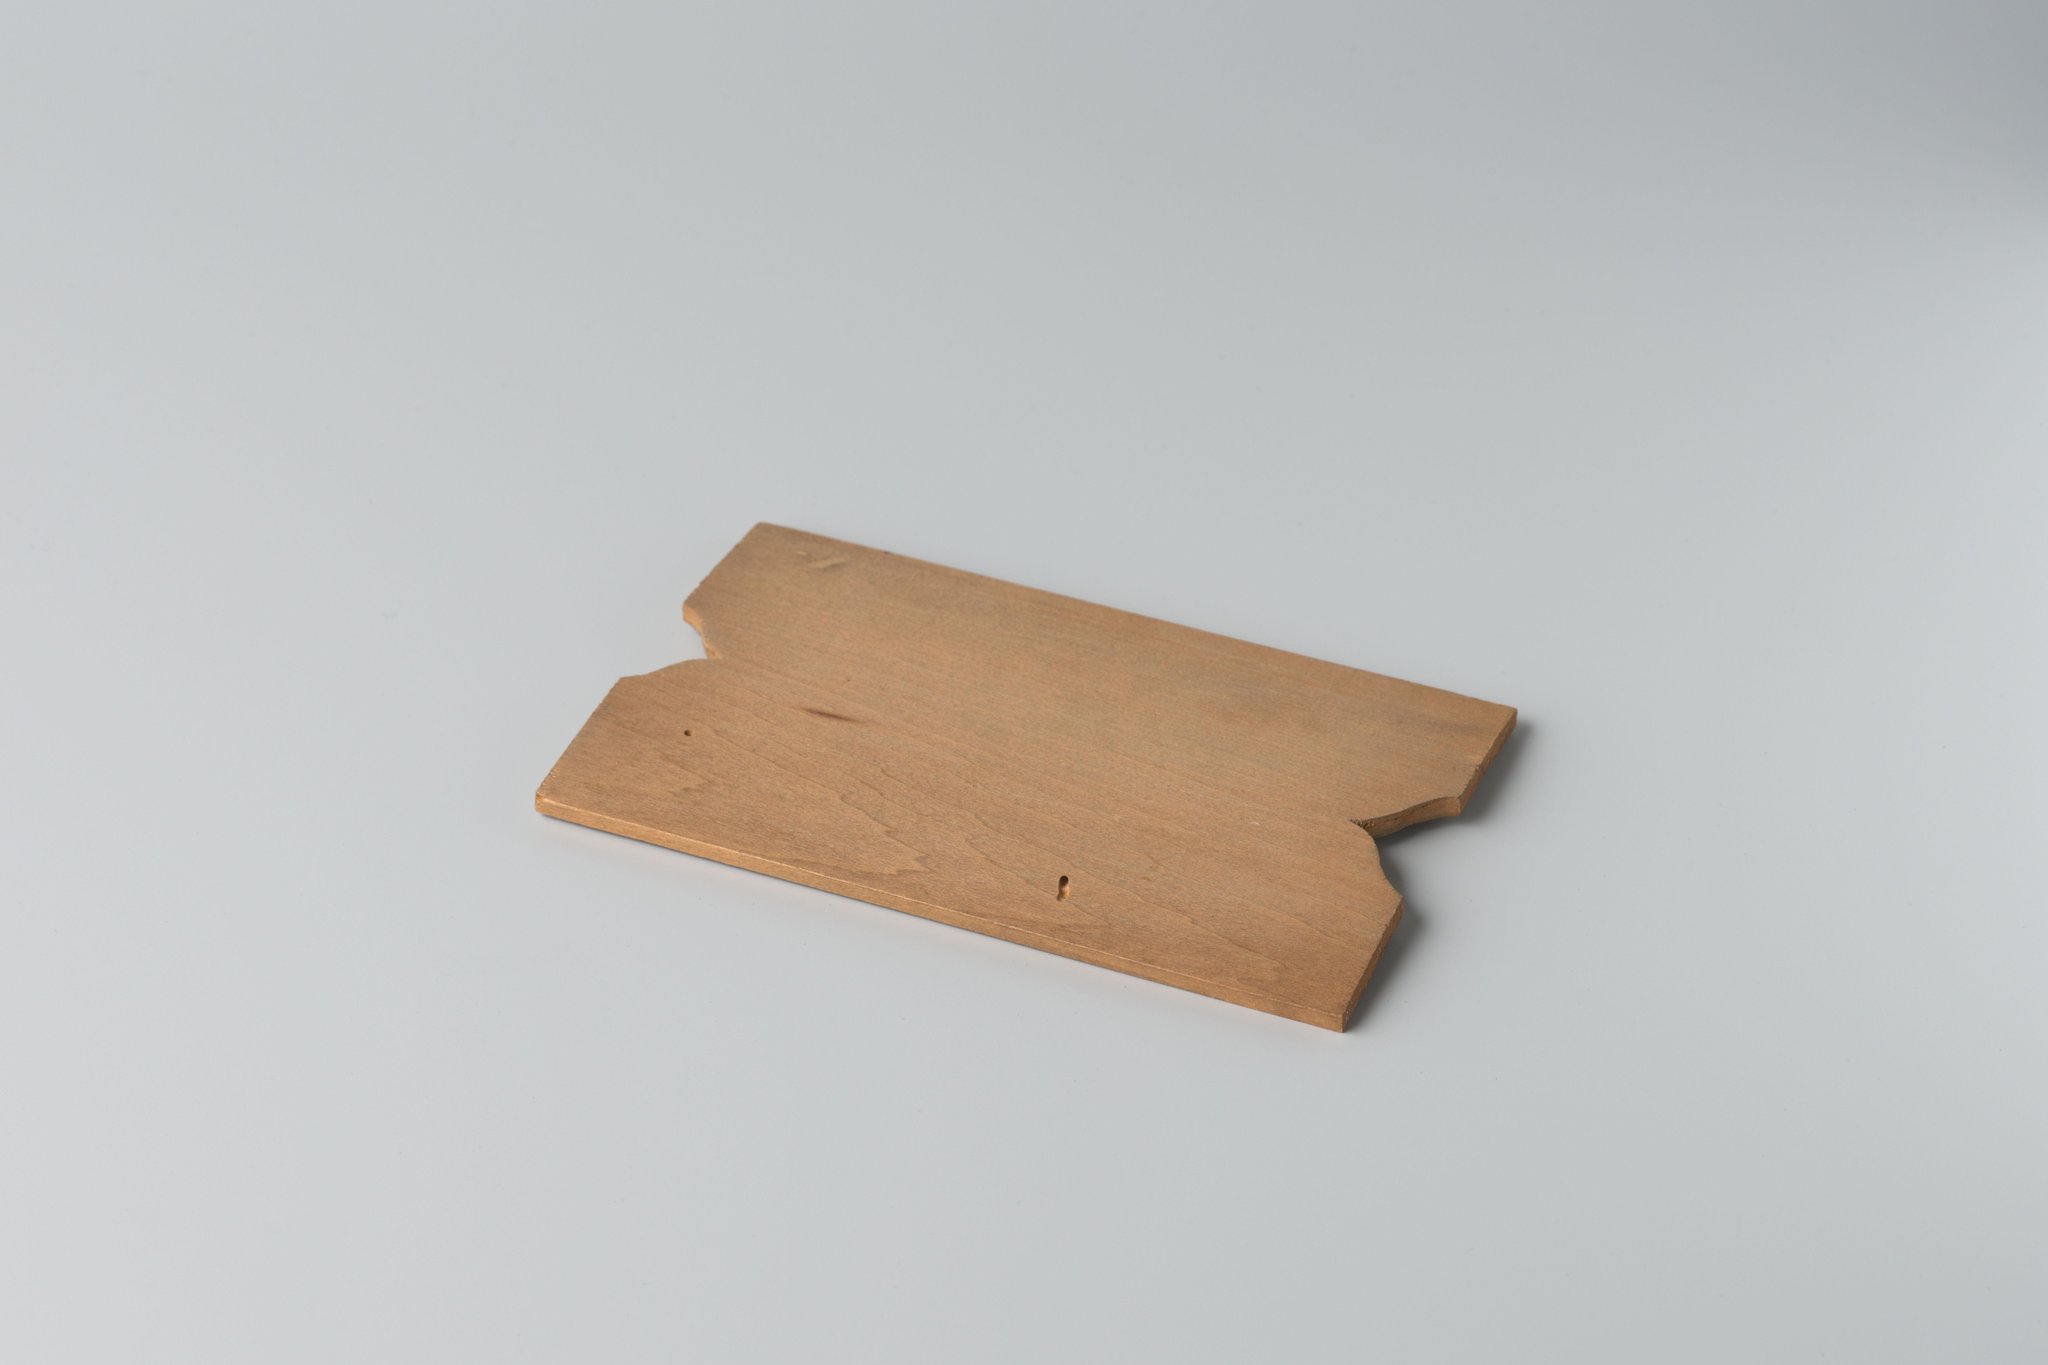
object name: miniature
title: Tafelblad van without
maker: Anonymous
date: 1676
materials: without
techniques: without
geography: amsterdam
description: Tafelblad, rechthoekig, van without. Aan de smalle zijde versierd met een uitgezaagde accolade.